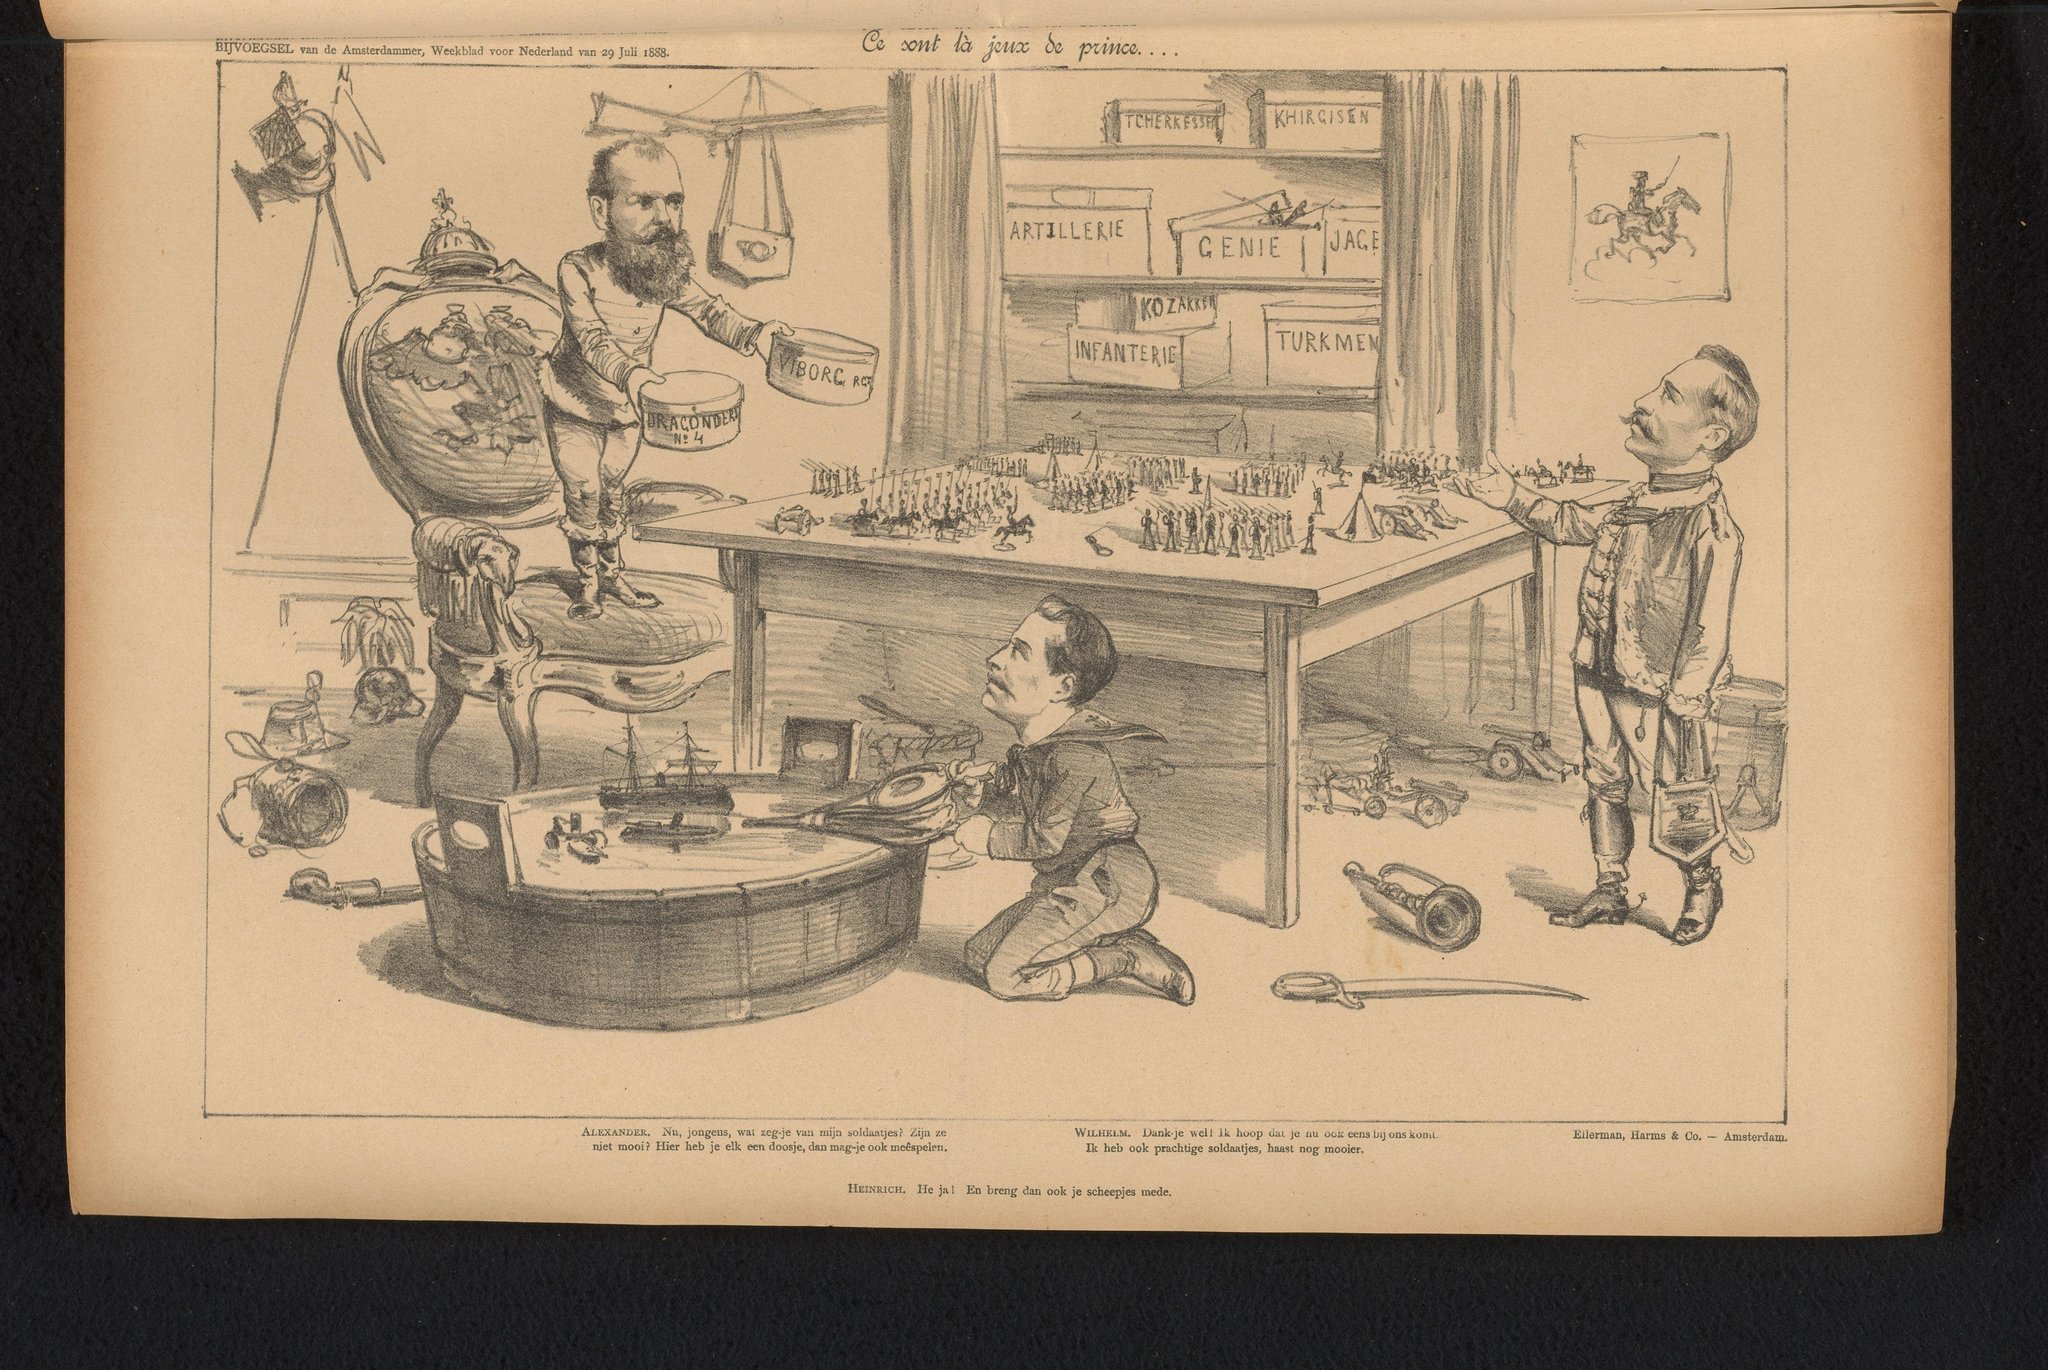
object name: cartoon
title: Ce sont là jeux de prince ...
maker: johan braakensiek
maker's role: draughtsman, print maker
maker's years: 1858-1940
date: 1888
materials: paper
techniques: lithograph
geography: amsterdam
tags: wilhelm ii (keizer van duitsland), (playing with) toys, political caricatures and satires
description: De Russische tsaar Alexander III, de Duitse keizer Wilhelm II en 'Heinrich' als jongens spelend met soldaatjes.